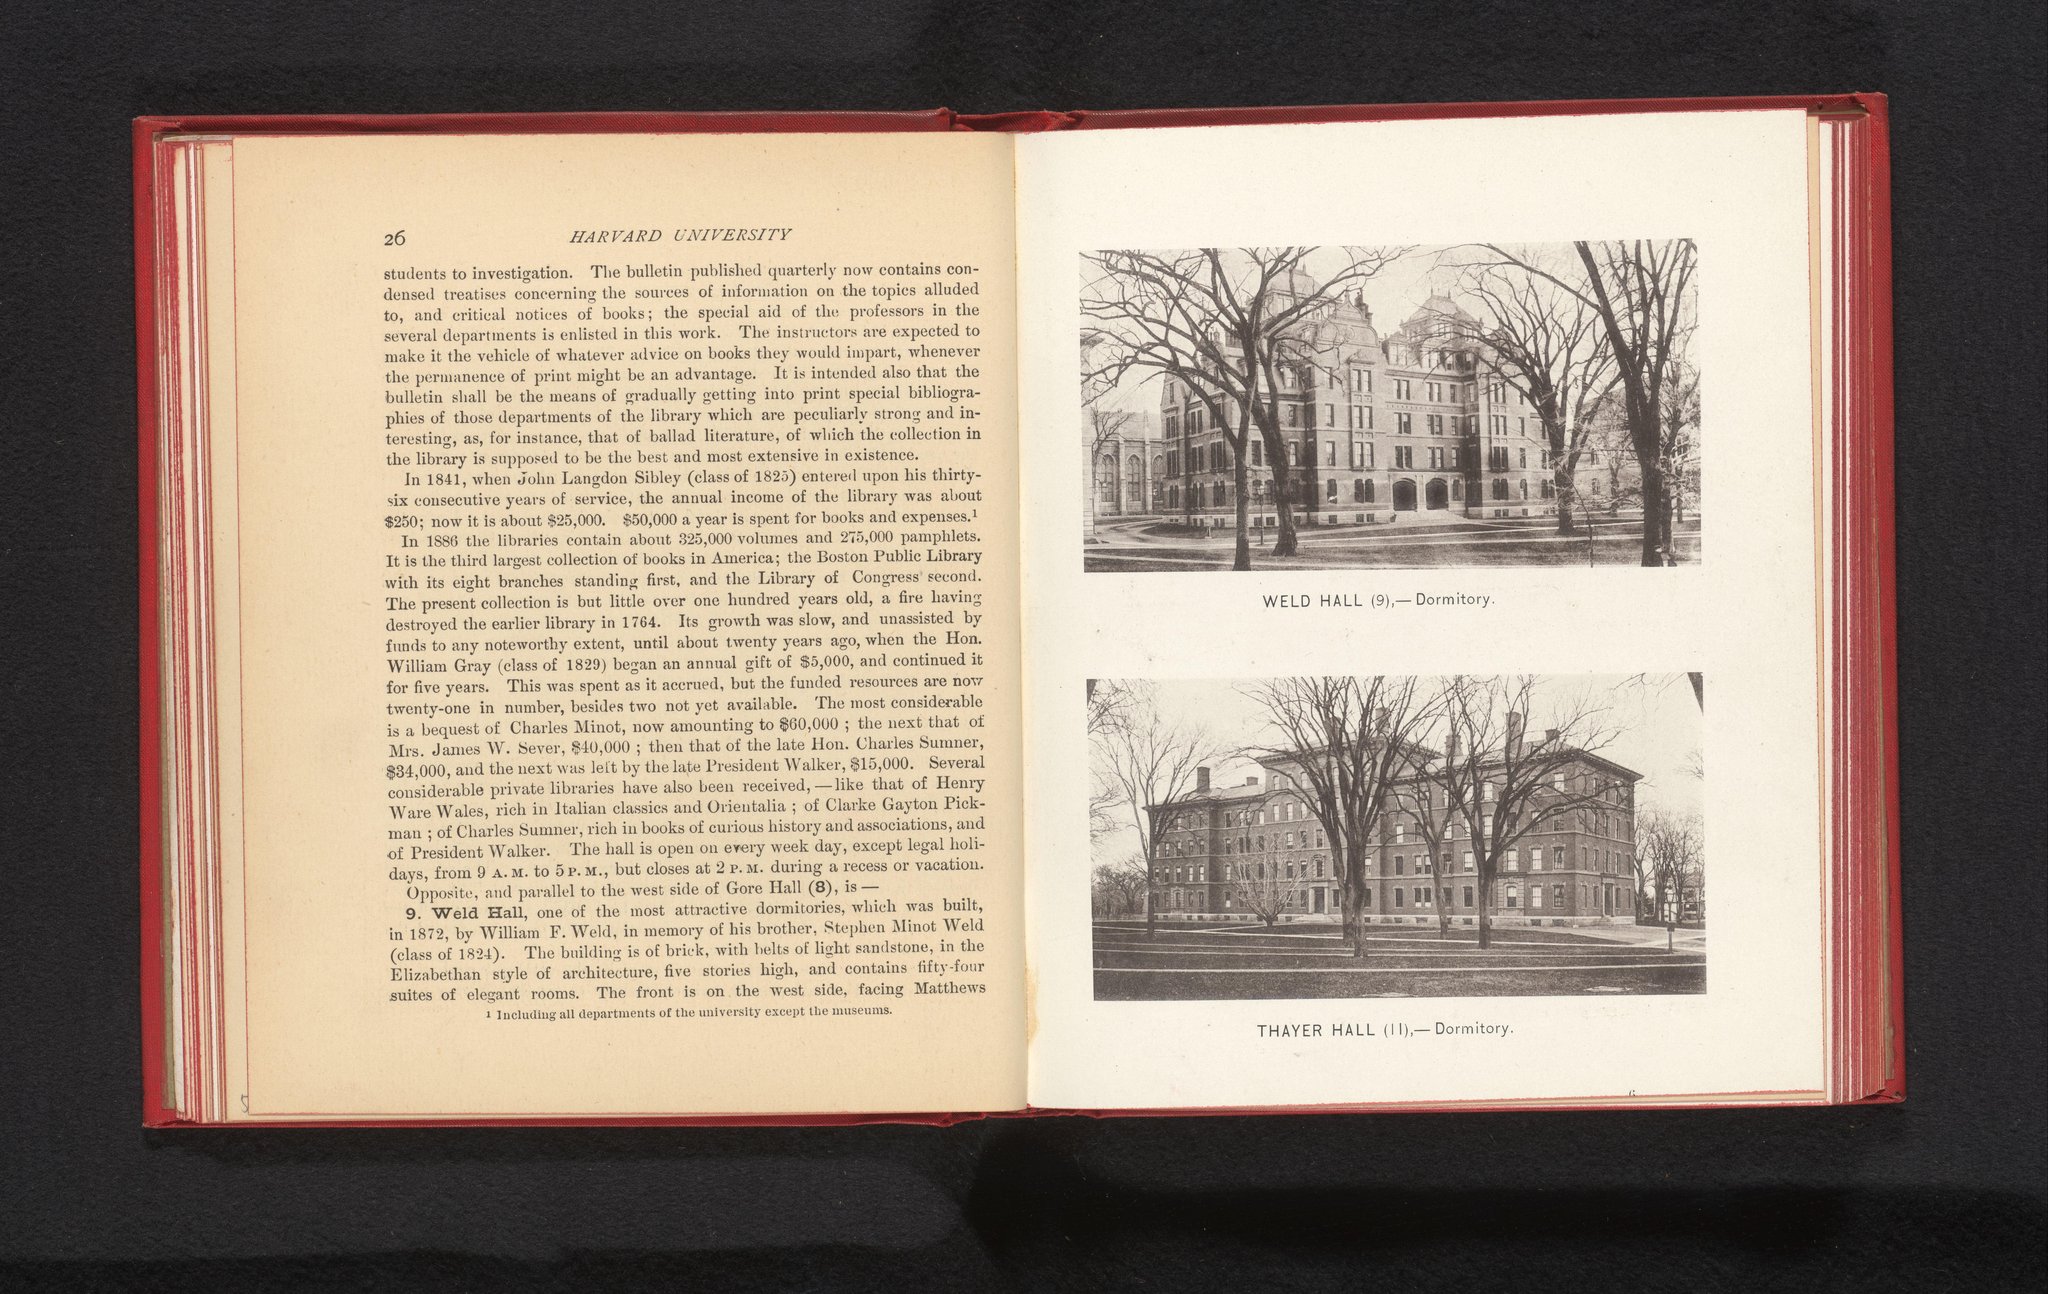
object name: page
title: Weld Hall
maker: Anonymous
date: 1881-1886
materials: paper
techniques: photograph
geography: cambridge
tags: university building, college, façade (of house or building)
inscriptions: number: ‘(9) (11)’